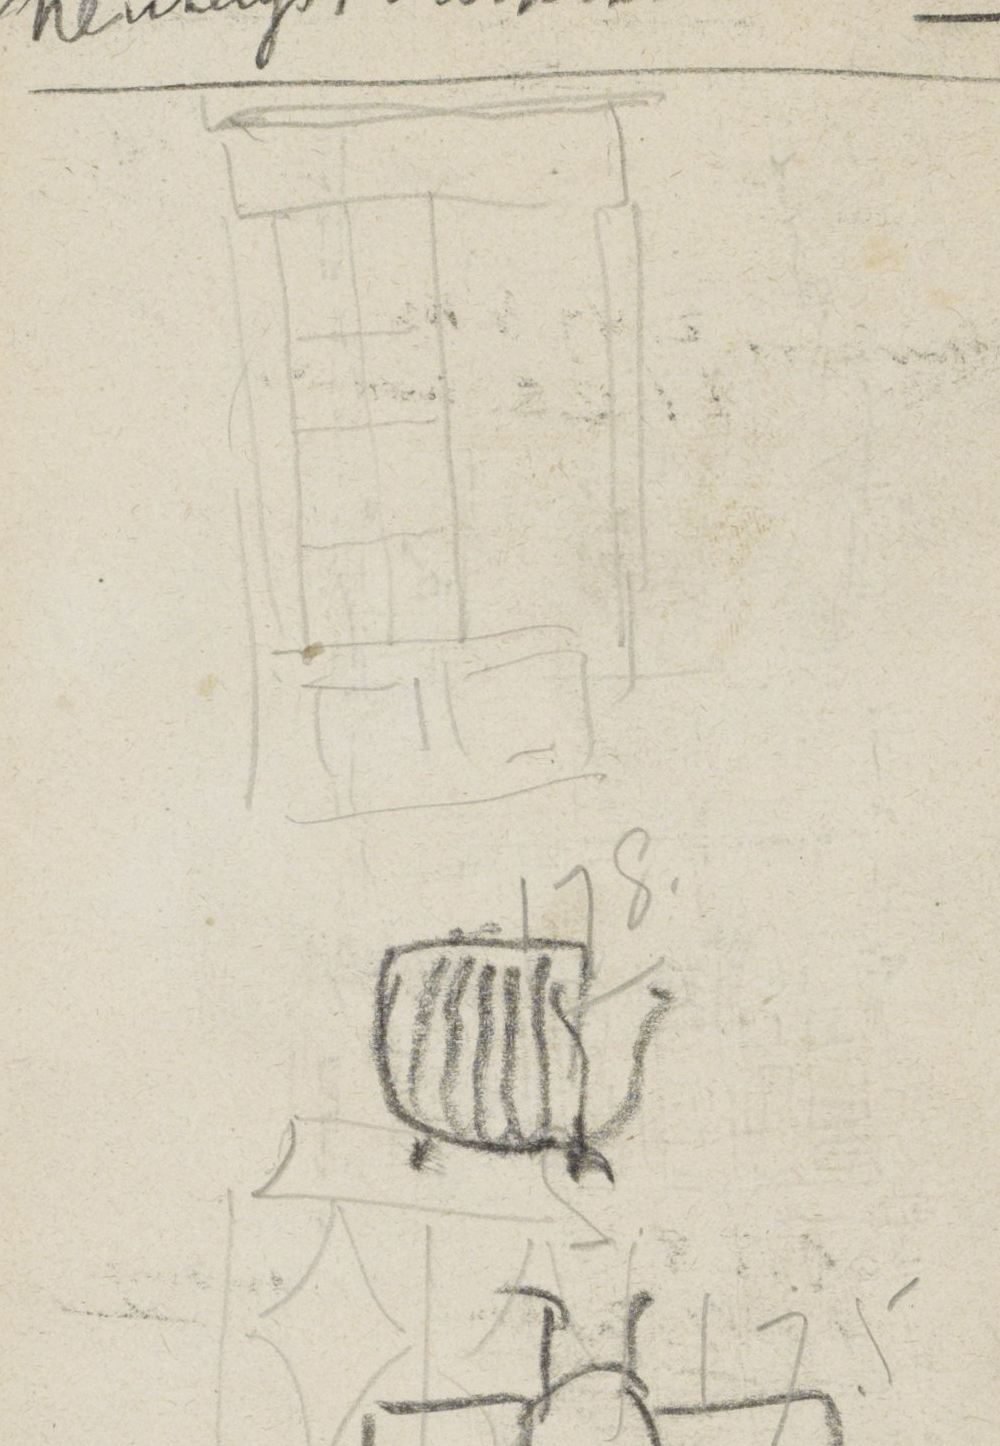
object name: sketchbook leaf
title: Studieblad, mogelijk met meubels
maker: george hendrik breitner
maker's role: draughtsman, painter, print maker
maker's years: 1857-1923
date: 1900-1901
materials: chalk, paper, pencil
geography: amsterdam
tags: furniture and household effects, cupboard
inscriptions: address: ‘[...] Sarphatistraat 6’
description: Studieblad, mogelijk met meubels. Pagina 4 uit een schetsboek met 46 bladen vervaardigd te Amsterdam.